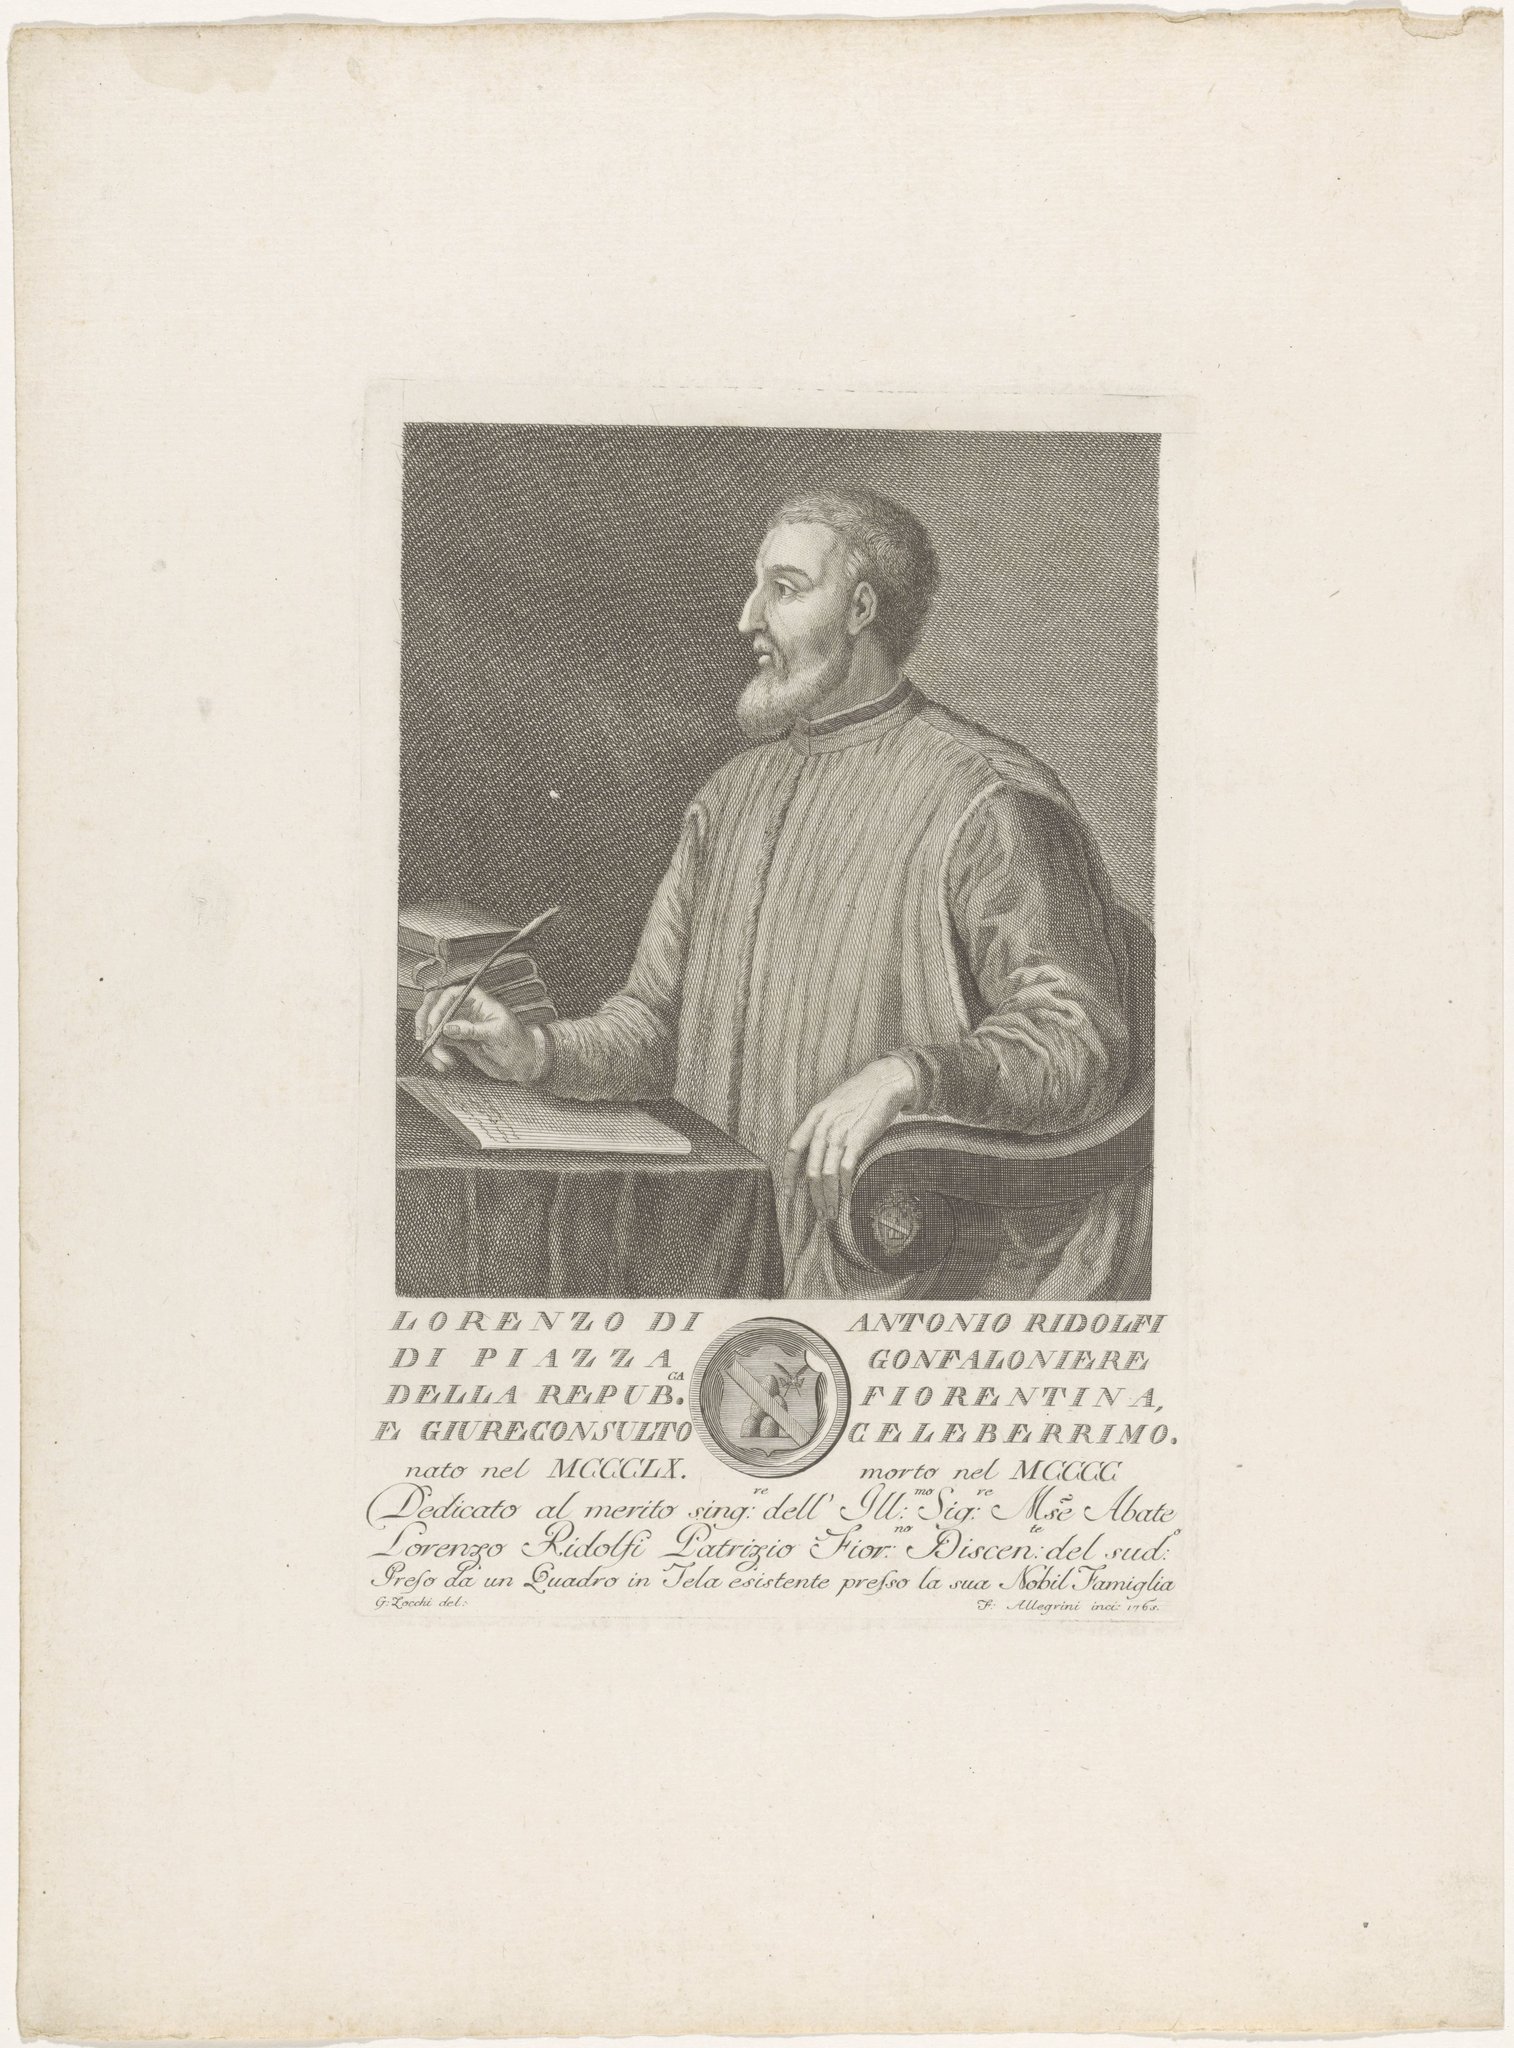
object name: print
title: Portret van Lorenzo Antonio Ridolfi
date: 1765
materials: paper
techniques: engraving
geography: italy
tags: historical persons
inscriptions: collector's mark: Lugt 2228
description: Portret van jurist Lorenzo Antonio Ridolfi ten halven lijve, zittend achter een bureau met een schrijfveer in zijn rechterhand. Op het bureau een stapel boeken. Onder het portret een tekst in het Italiaans en een wapenschild in een cirkelvormig kader.